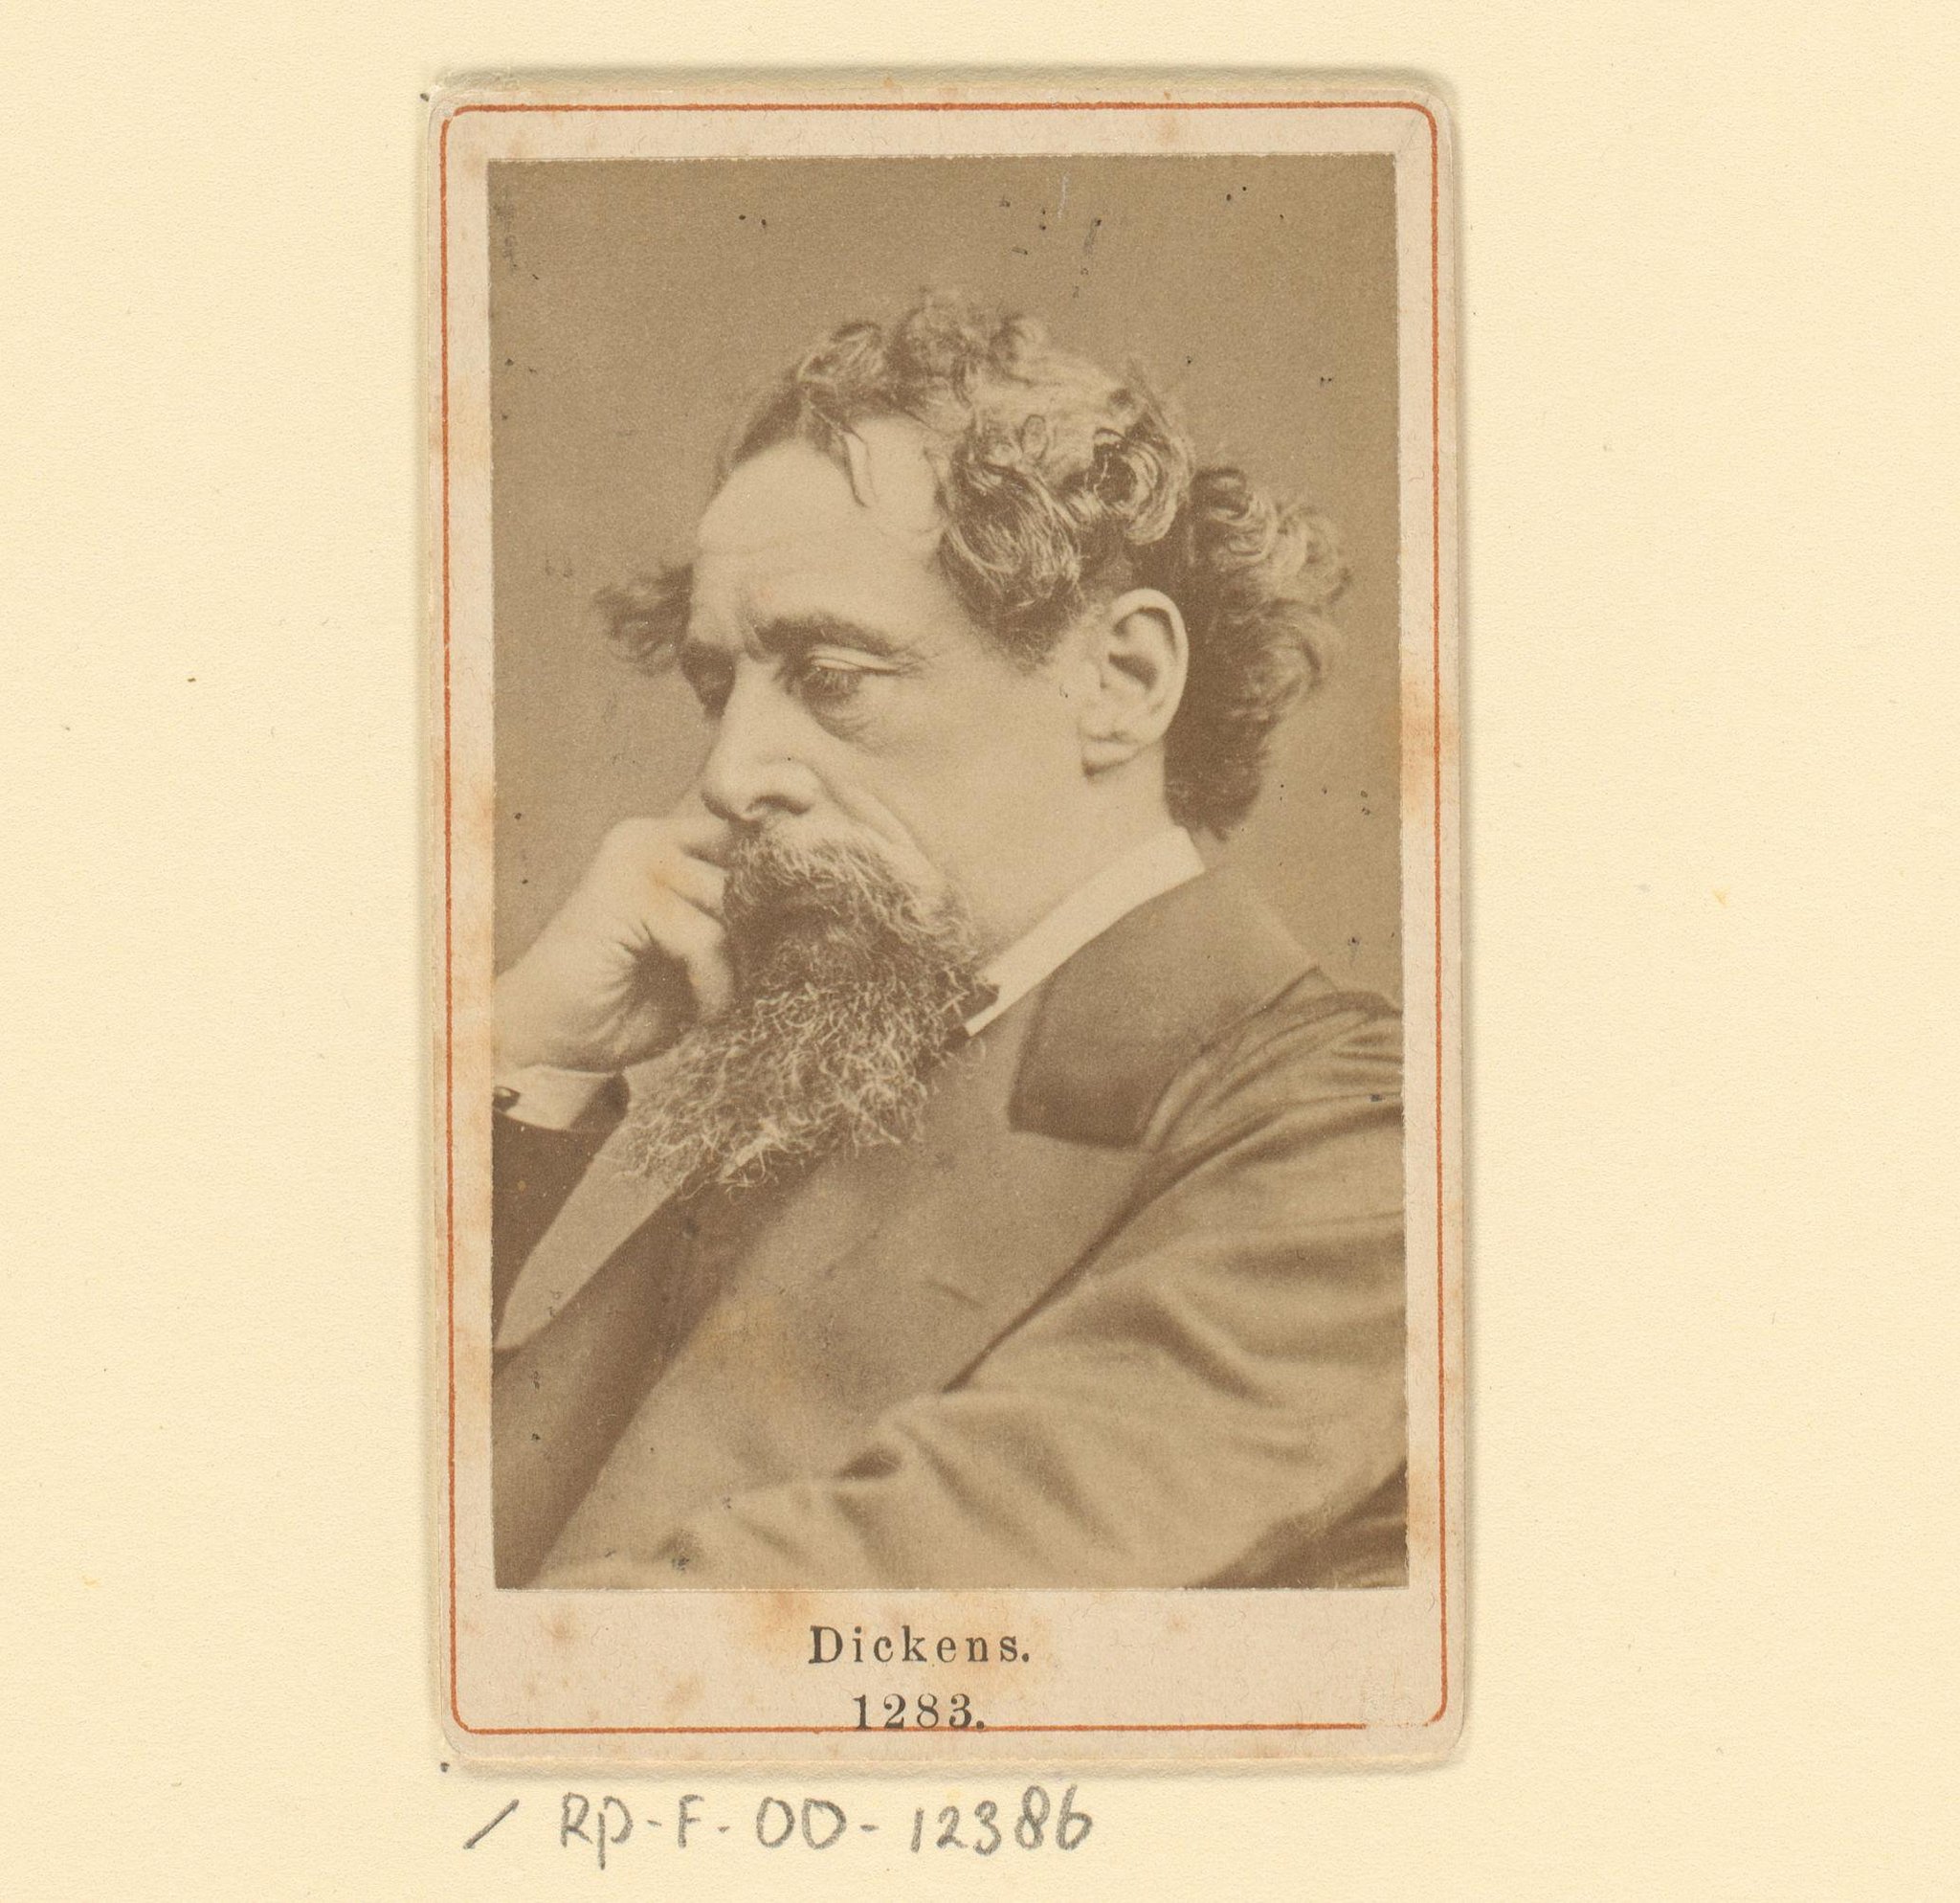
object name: photograph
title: Dickens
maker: Anonymous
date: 1851-1860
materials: paper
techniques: albumen print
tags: portsmouth, portrait of a writer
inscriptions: inscription: ‘f.’, number: ‘1283.’